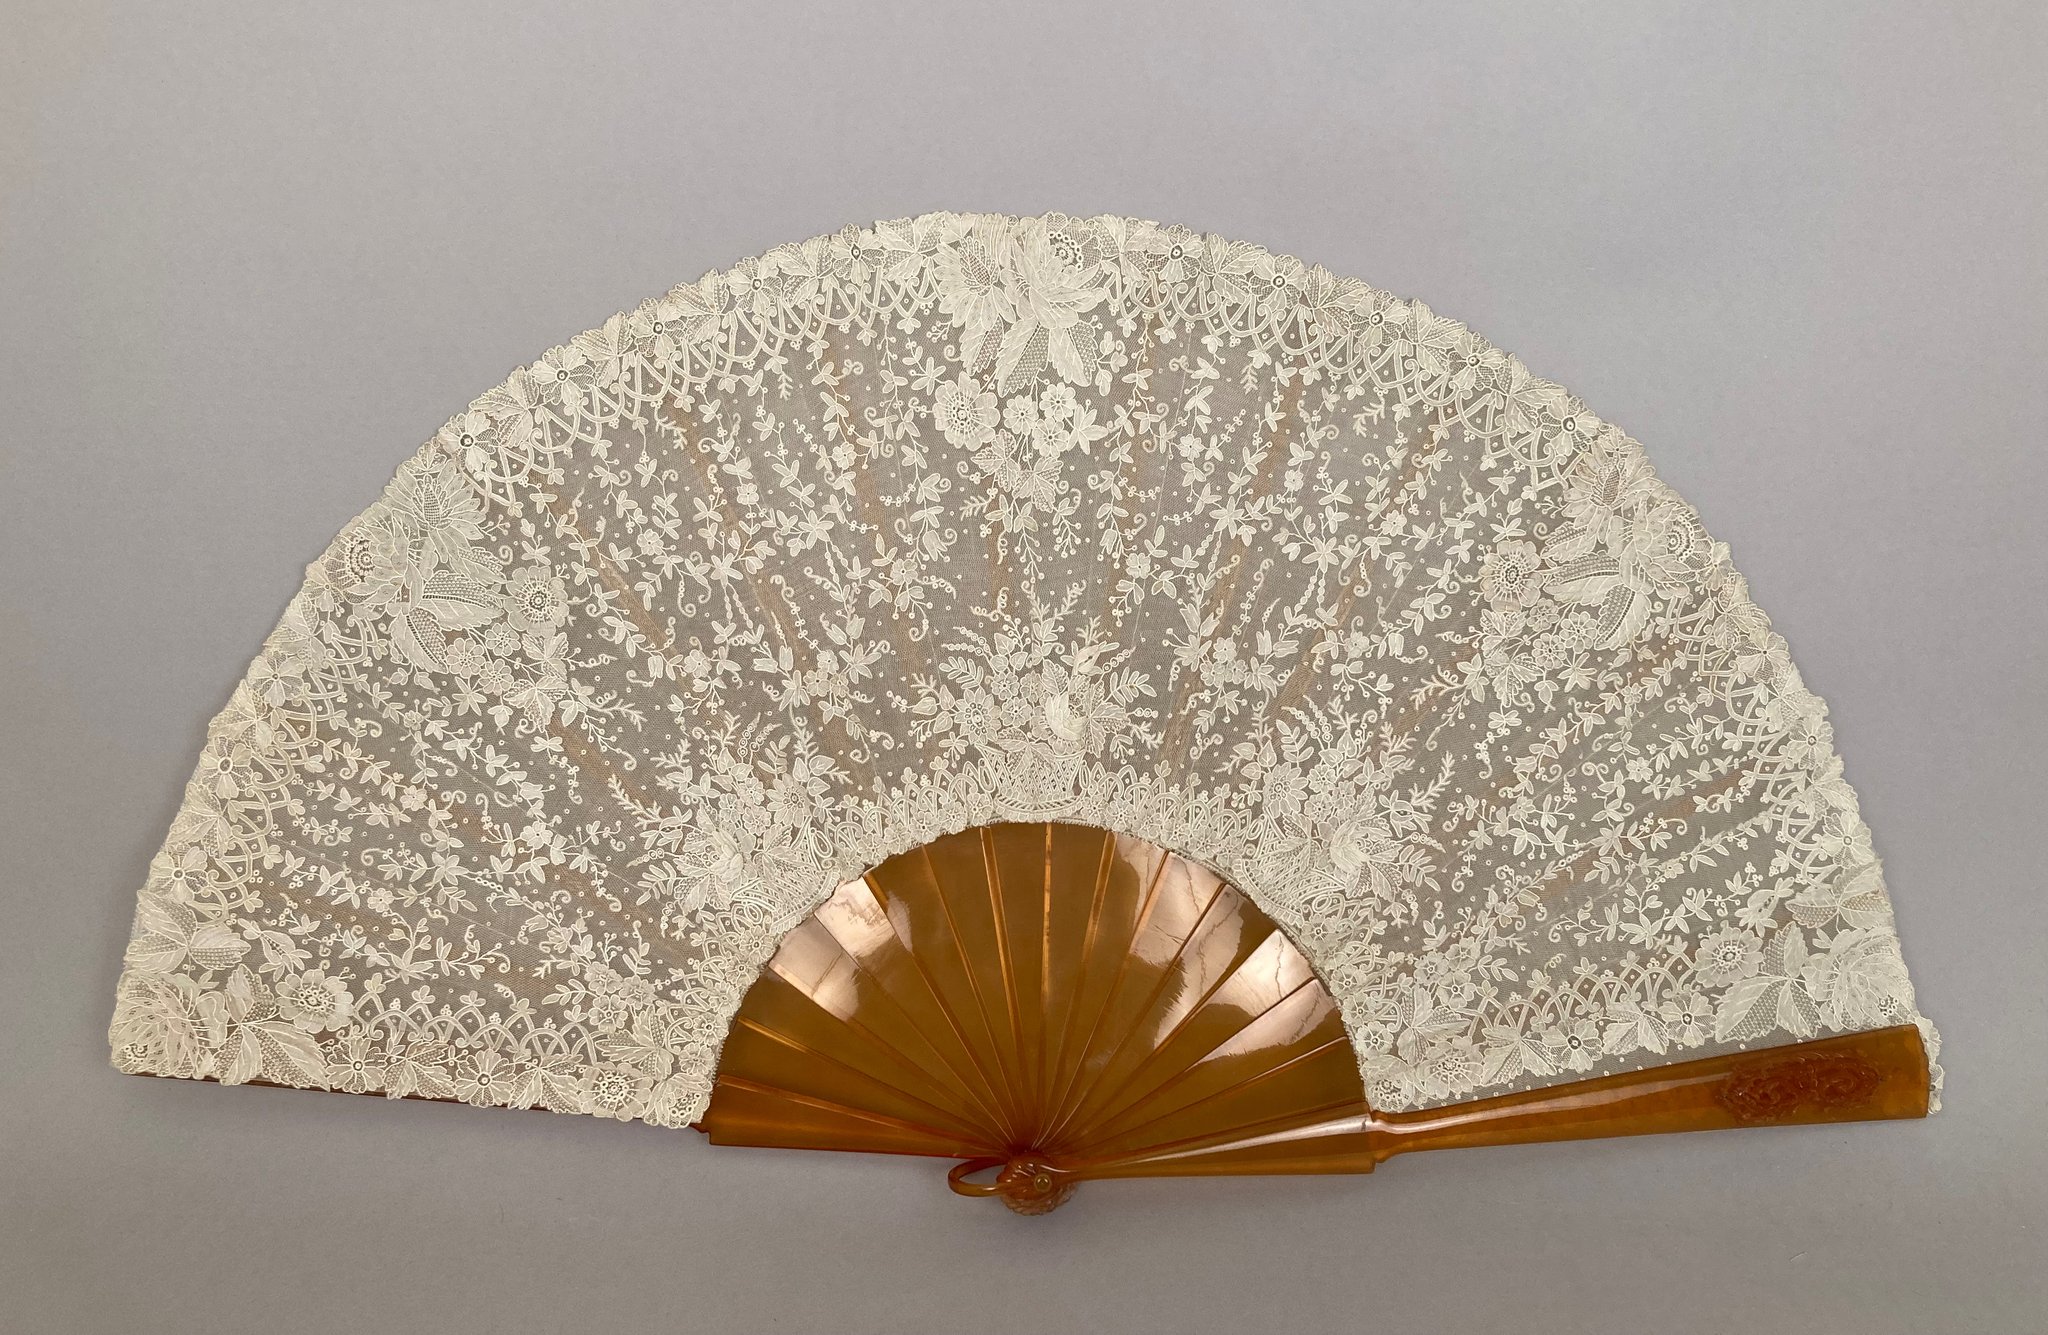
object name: fan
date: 1851-1900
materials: lace, shell